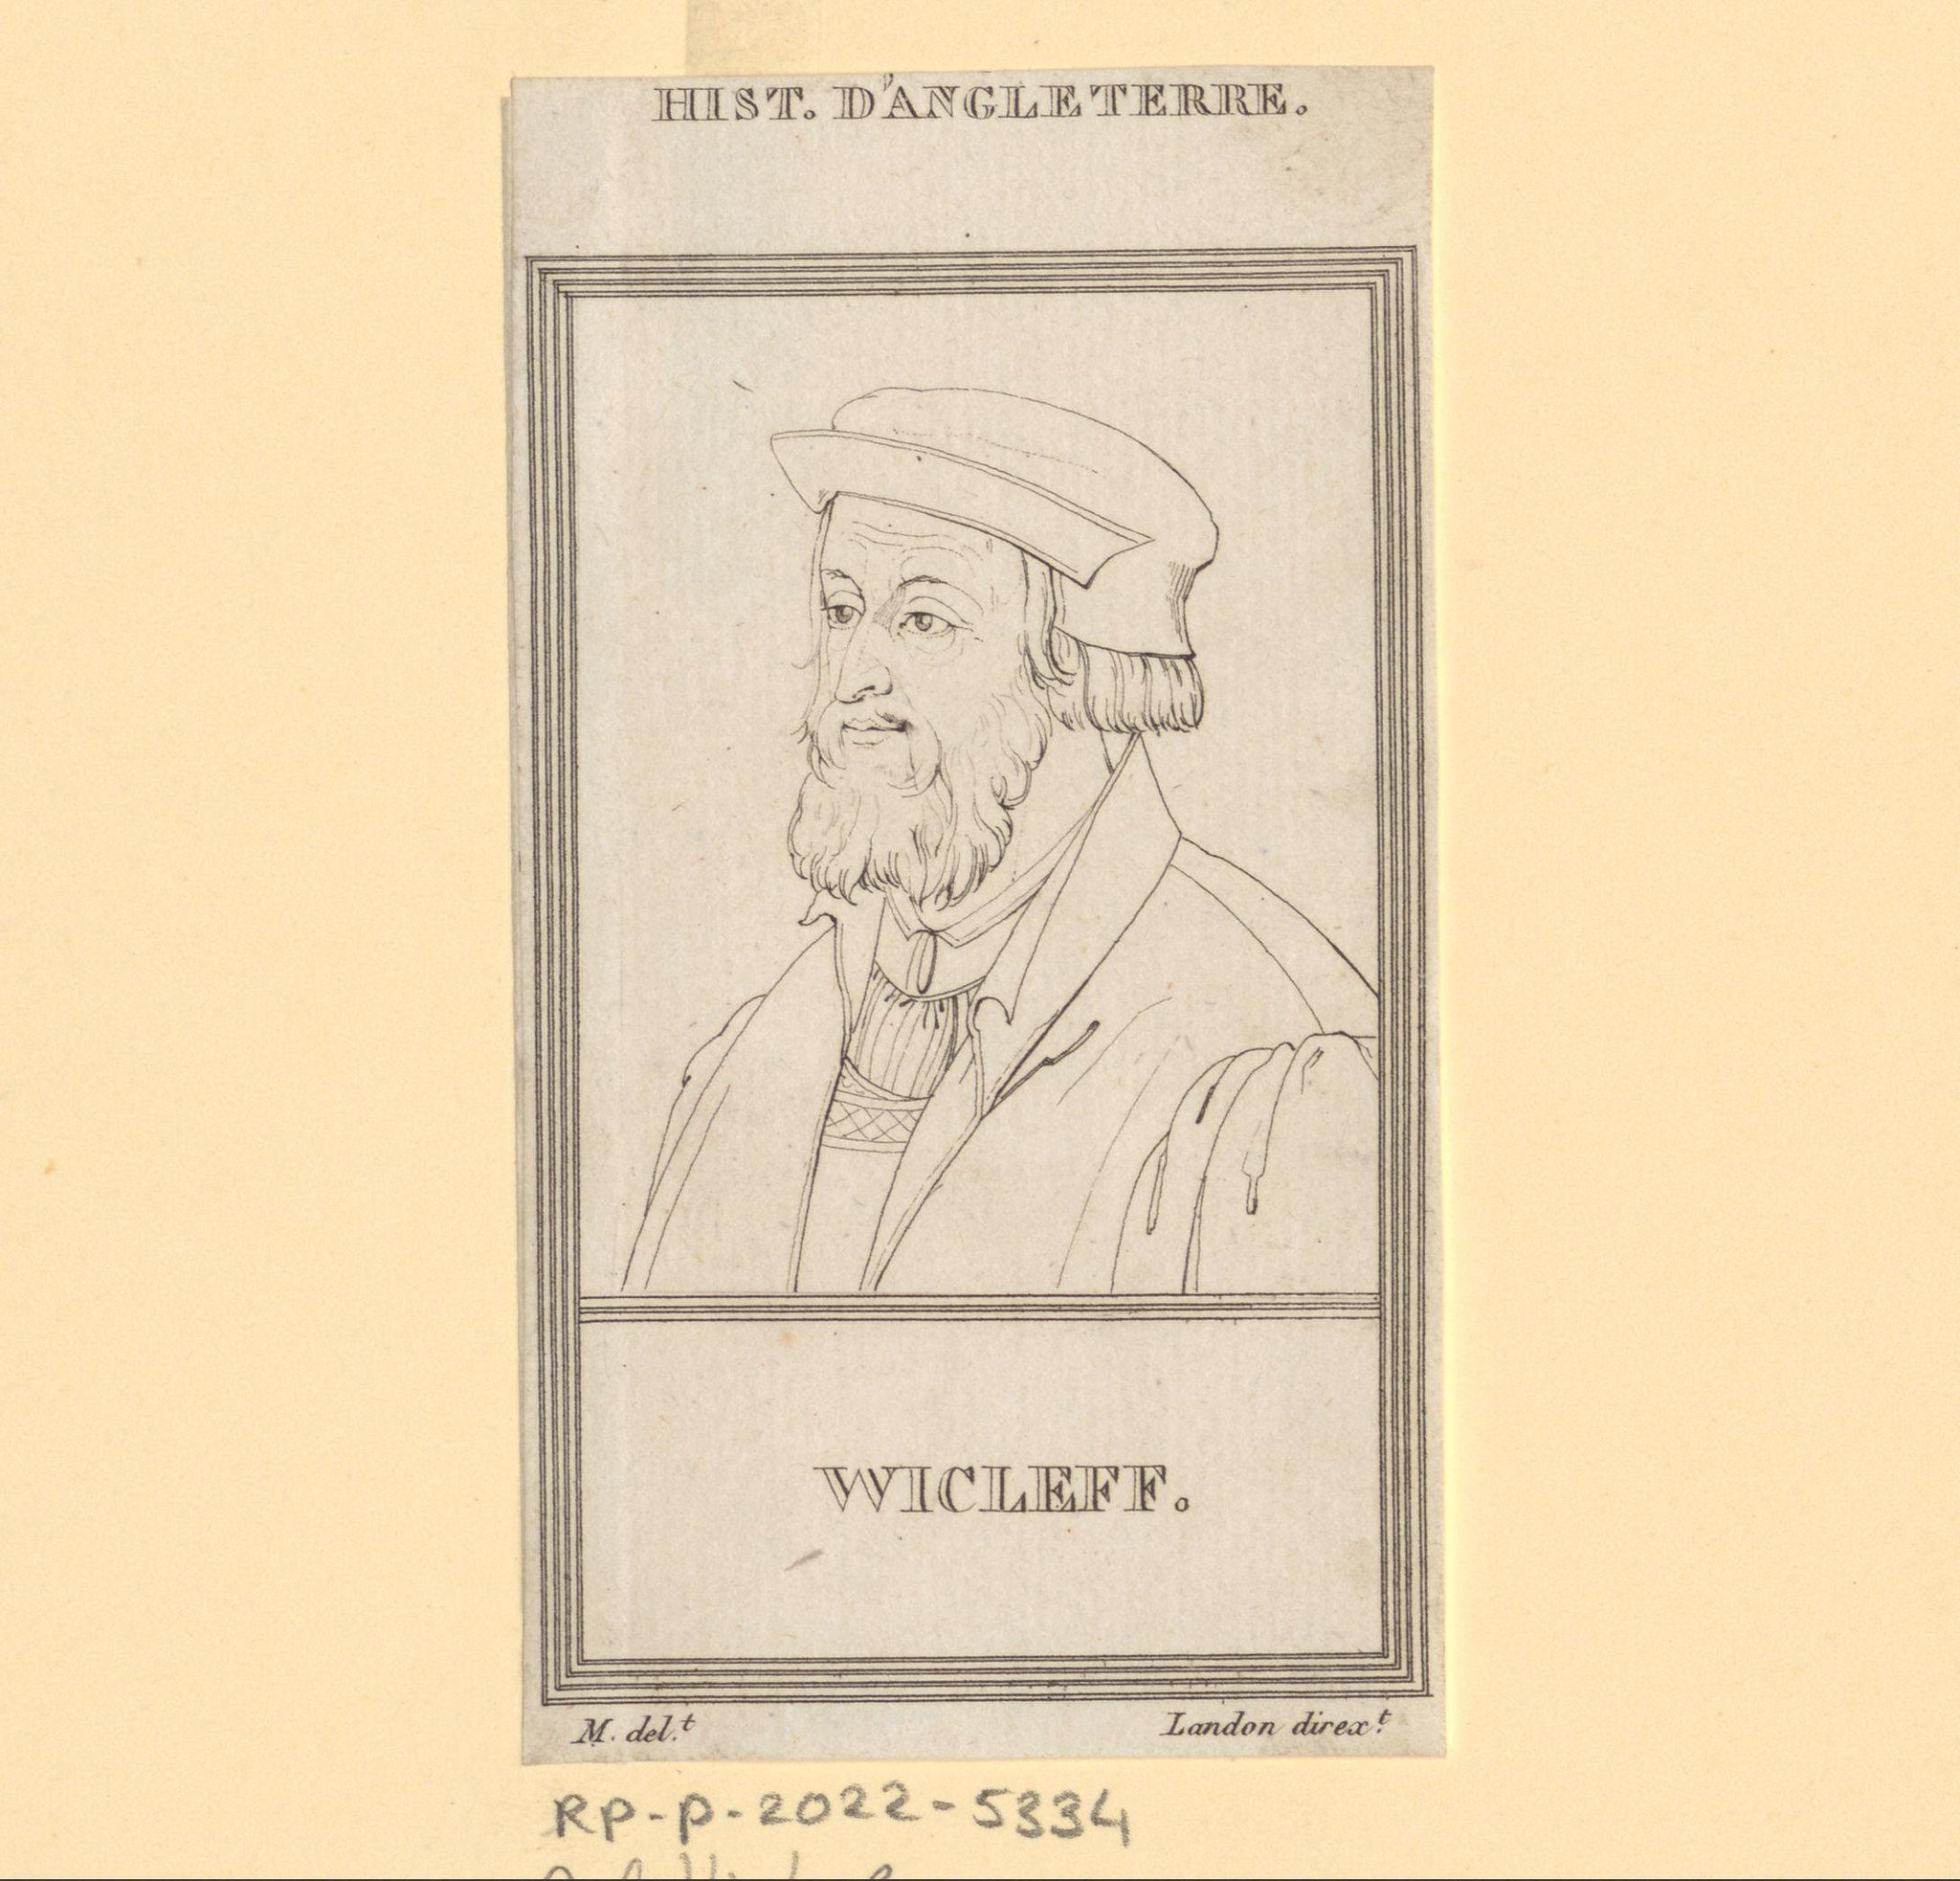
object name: print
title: Portret van John Wyclif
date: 1806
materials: paper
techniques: etching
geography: france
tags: theologian, historical persons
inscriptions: monogram: ‘M’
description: Prent waarschijnlijk uit: Landon, Charles Paul. Galerie historique des hommes les plus célèbres (...). Parijs: Imprimerie des Annales du Musée, 1806, dl. 8.